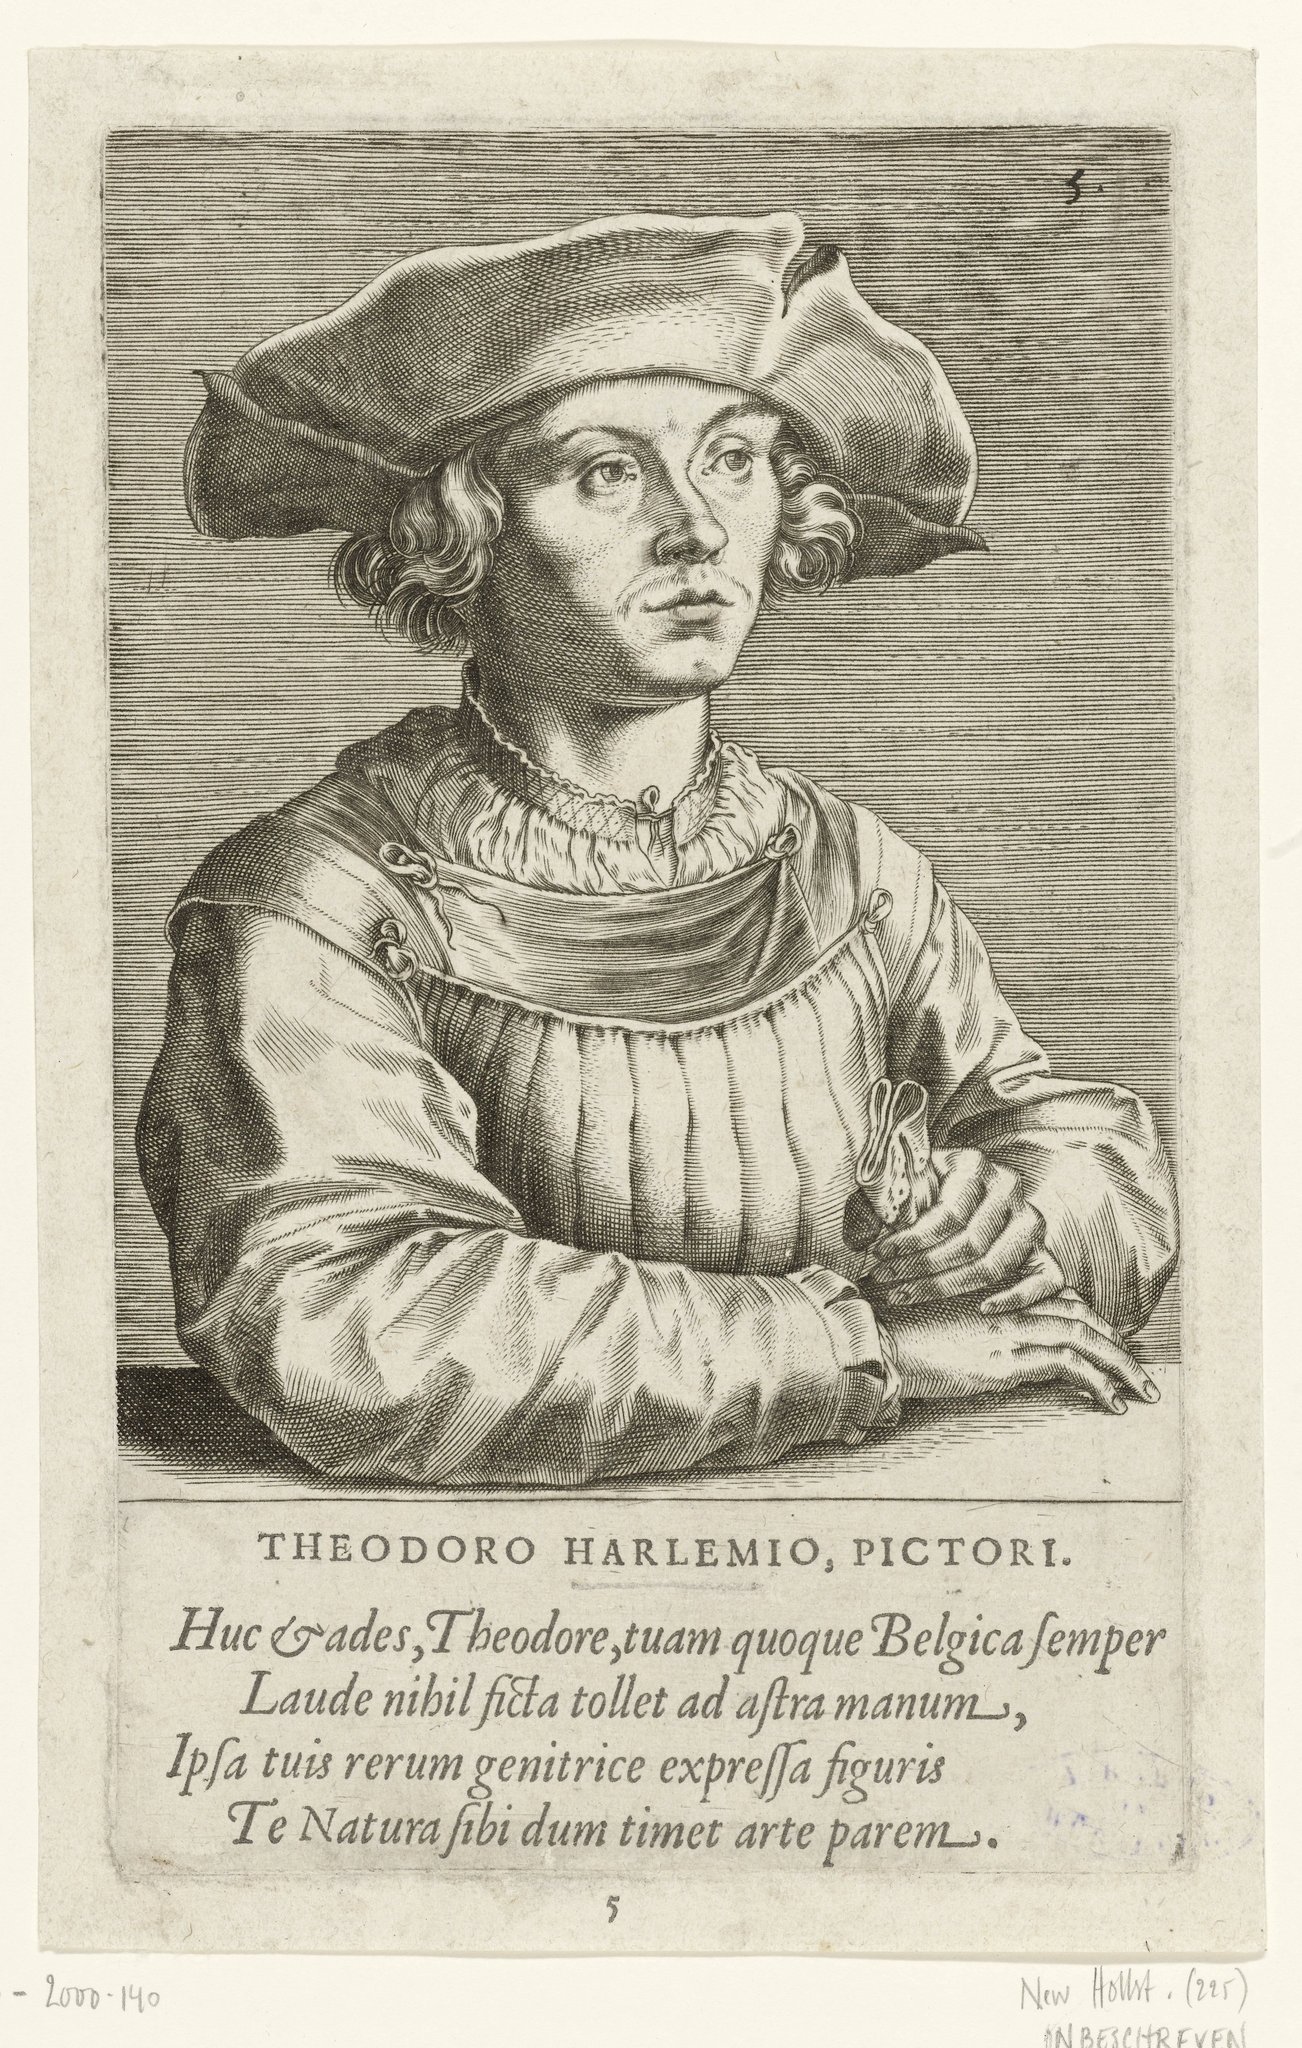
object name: print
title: Portret van Barent van Orley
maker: cornelis cort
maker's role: print maker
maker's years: 1533-1578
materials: paper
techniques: engraving, letterpress printing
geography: antwerp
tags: brussels, painter, bernard van orley, portrait, self-portrait of painter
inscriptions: number: ‘5’, collector's mark: Lugt 2228, title: ‘THEODORO HARLEMIO, PICTORI’, caption: ‘Huc et ades/Theodore, tuam quoque Belgica semper/Laude nihil ficta tollet ad astra manum,/Ipsa tuis rerum genitrice expressa figuris/Te natura sibi dum timet arte parem.’, collector's mark: Lugt 2760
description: Portret van de schilder Barent van Orley, ten halven lijve, naar links gekeerd, een baret met brede rand op het hoofd, handschoenen in de hand. Onder het portret een Latijns vers.